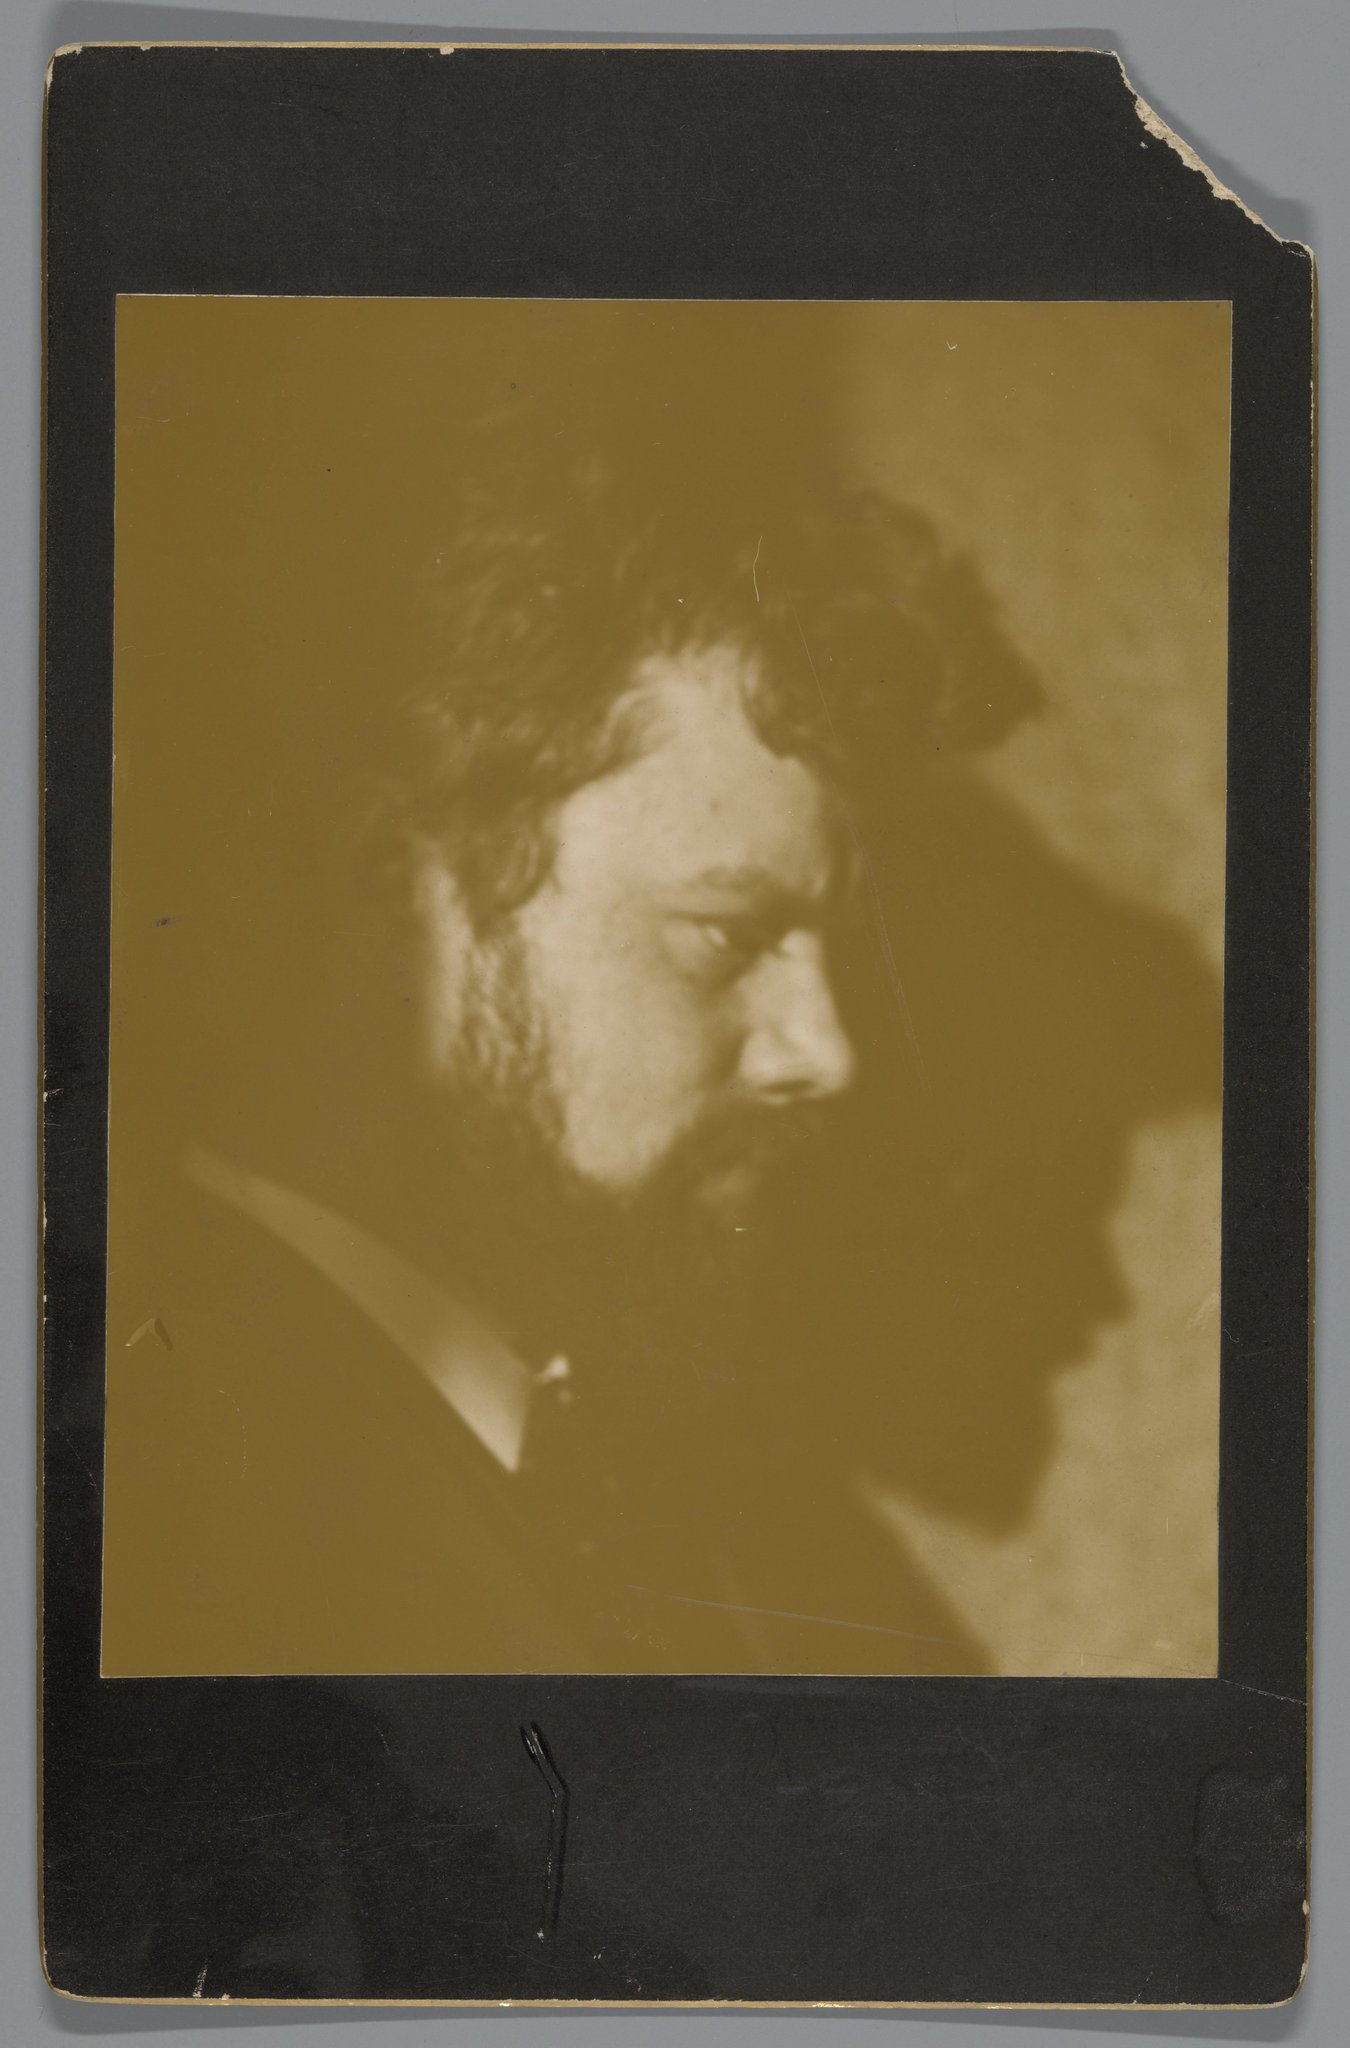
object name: photograph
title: Boeken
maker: willem witsen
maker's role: draughtsman, painter, print maker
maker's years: 1860-1923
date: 1860-1915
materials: cardboard, paper, photographic support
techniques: gelatin silver print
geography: amsterdam